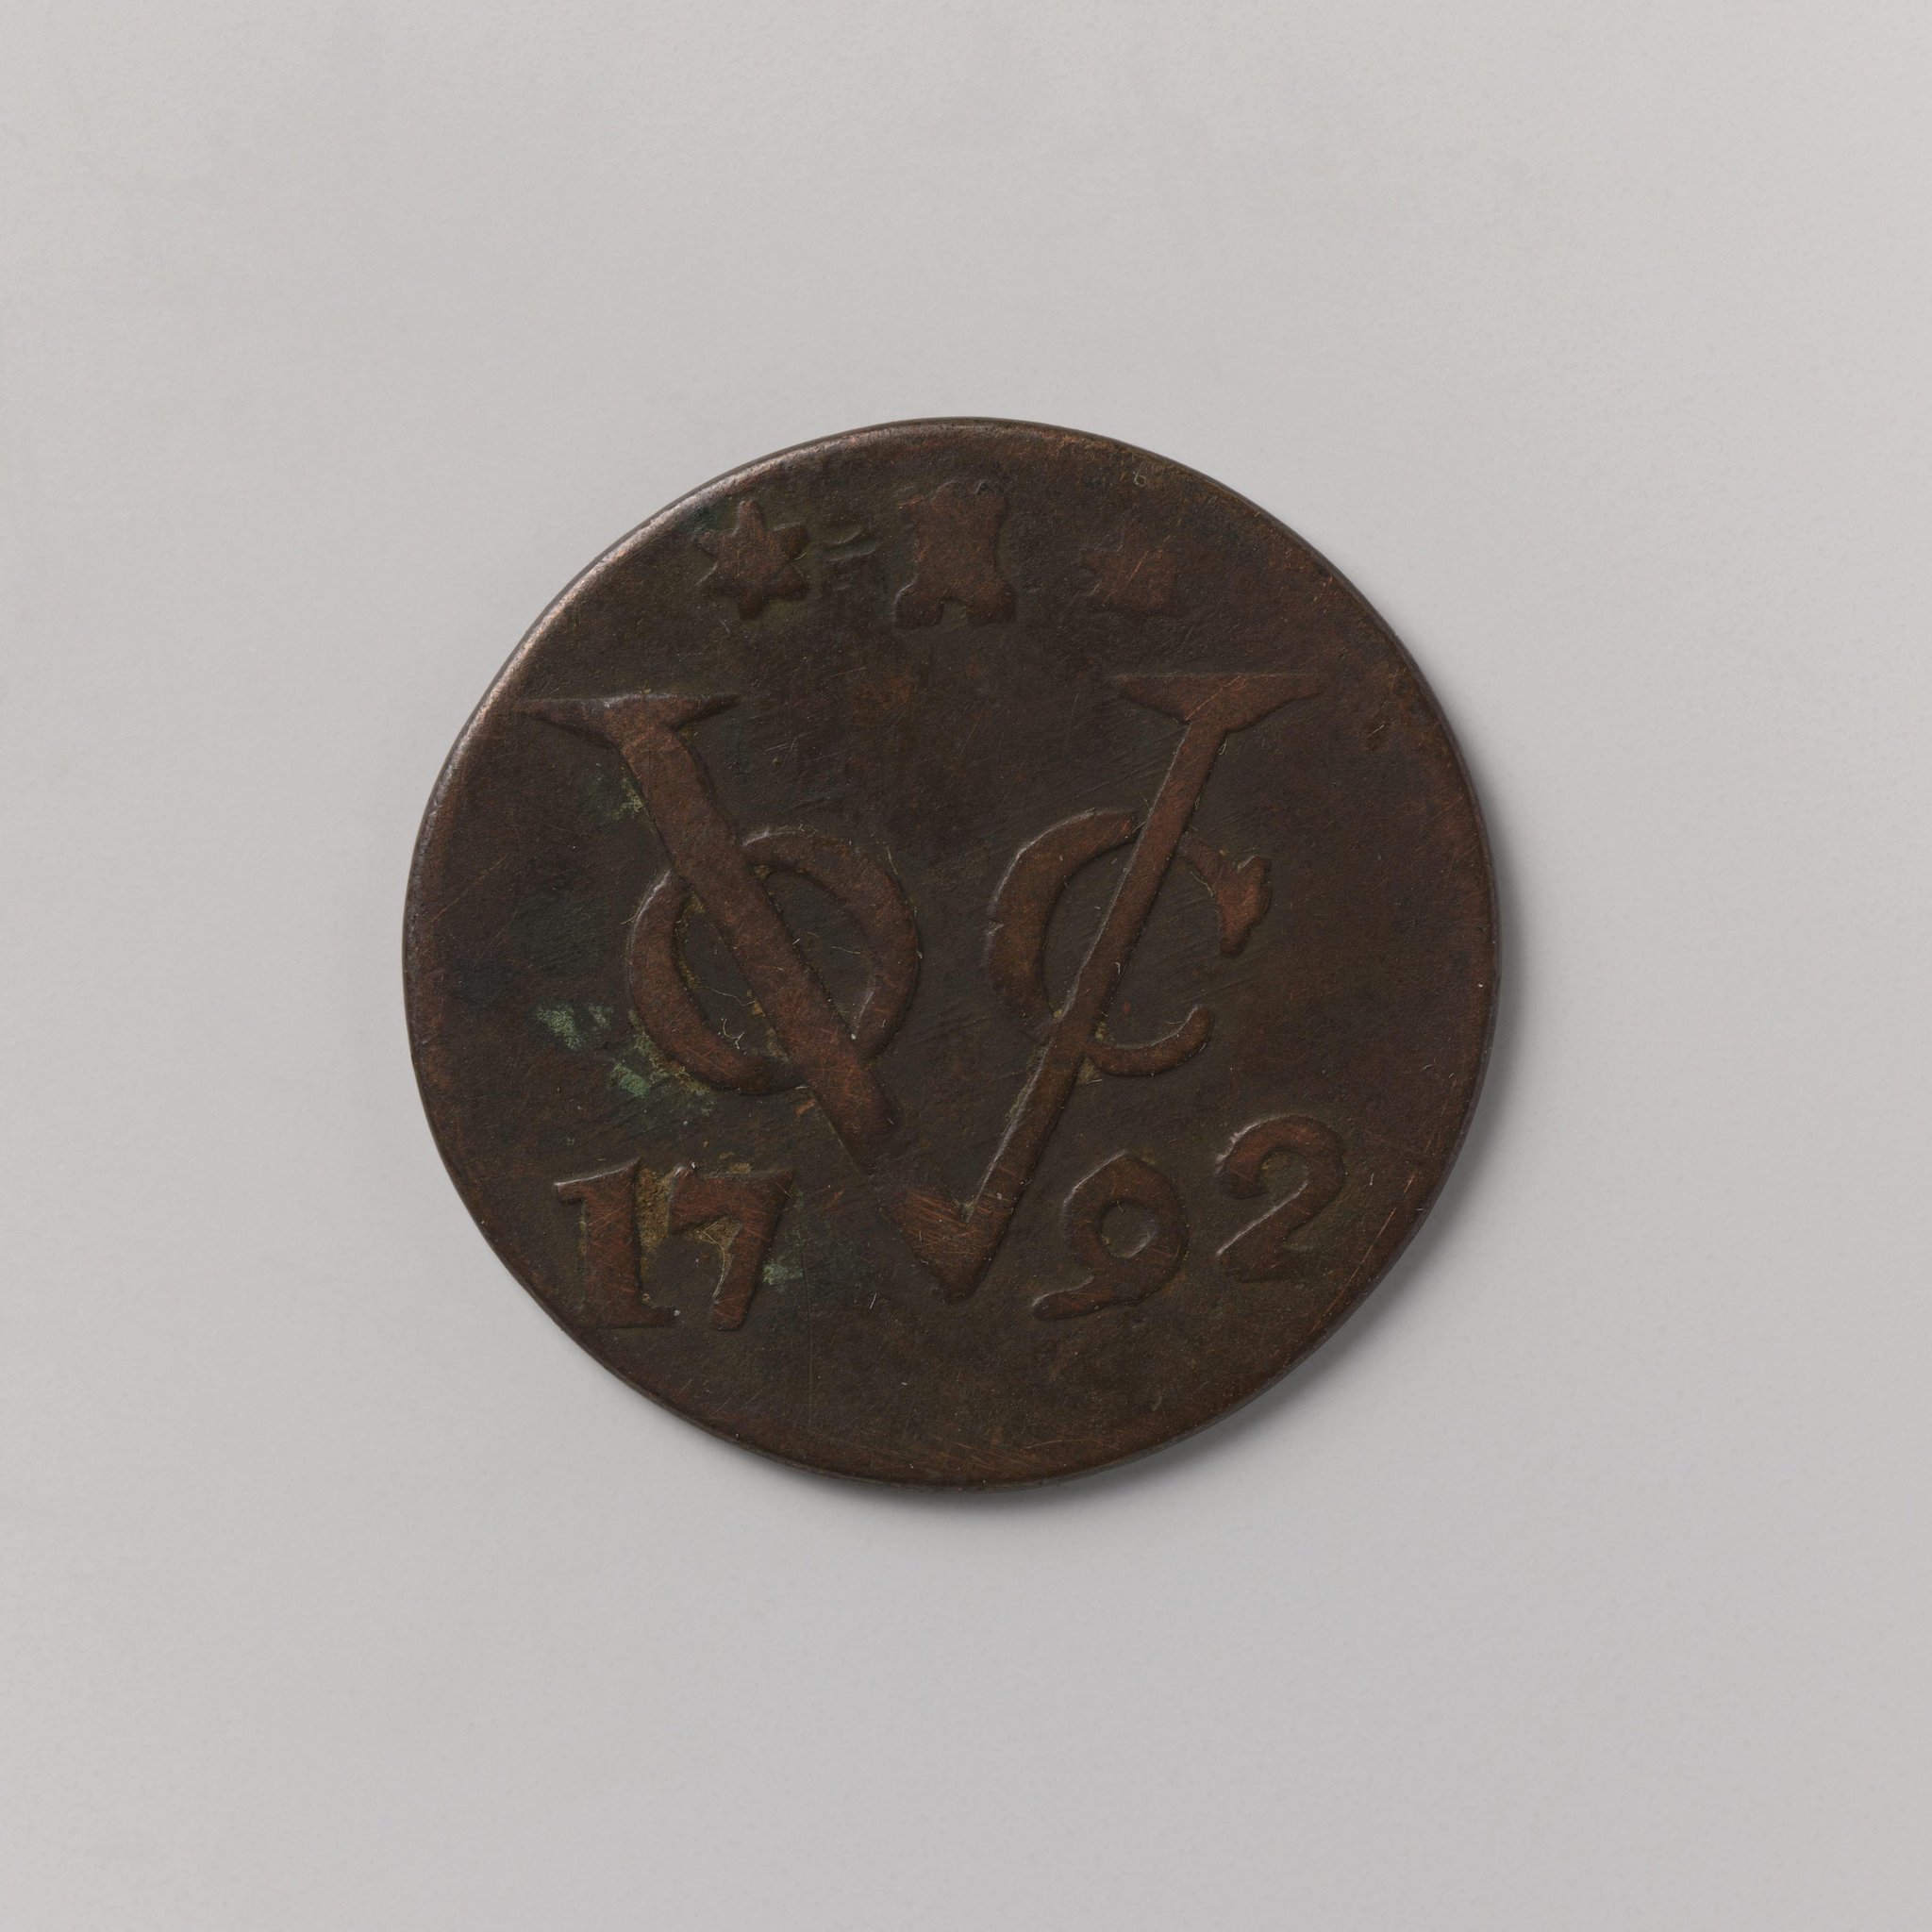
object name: coin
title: Duit van de VOC uit Zeeland, 1792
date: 1792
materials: copper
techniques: striking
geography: middelburg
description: Koperen munt. Voorzijde: gekroond wapenschild van Zeeland. Keerzijde: monogram van de VOC, waarboven muntteken en waaronder jaartal. Gladde rand.